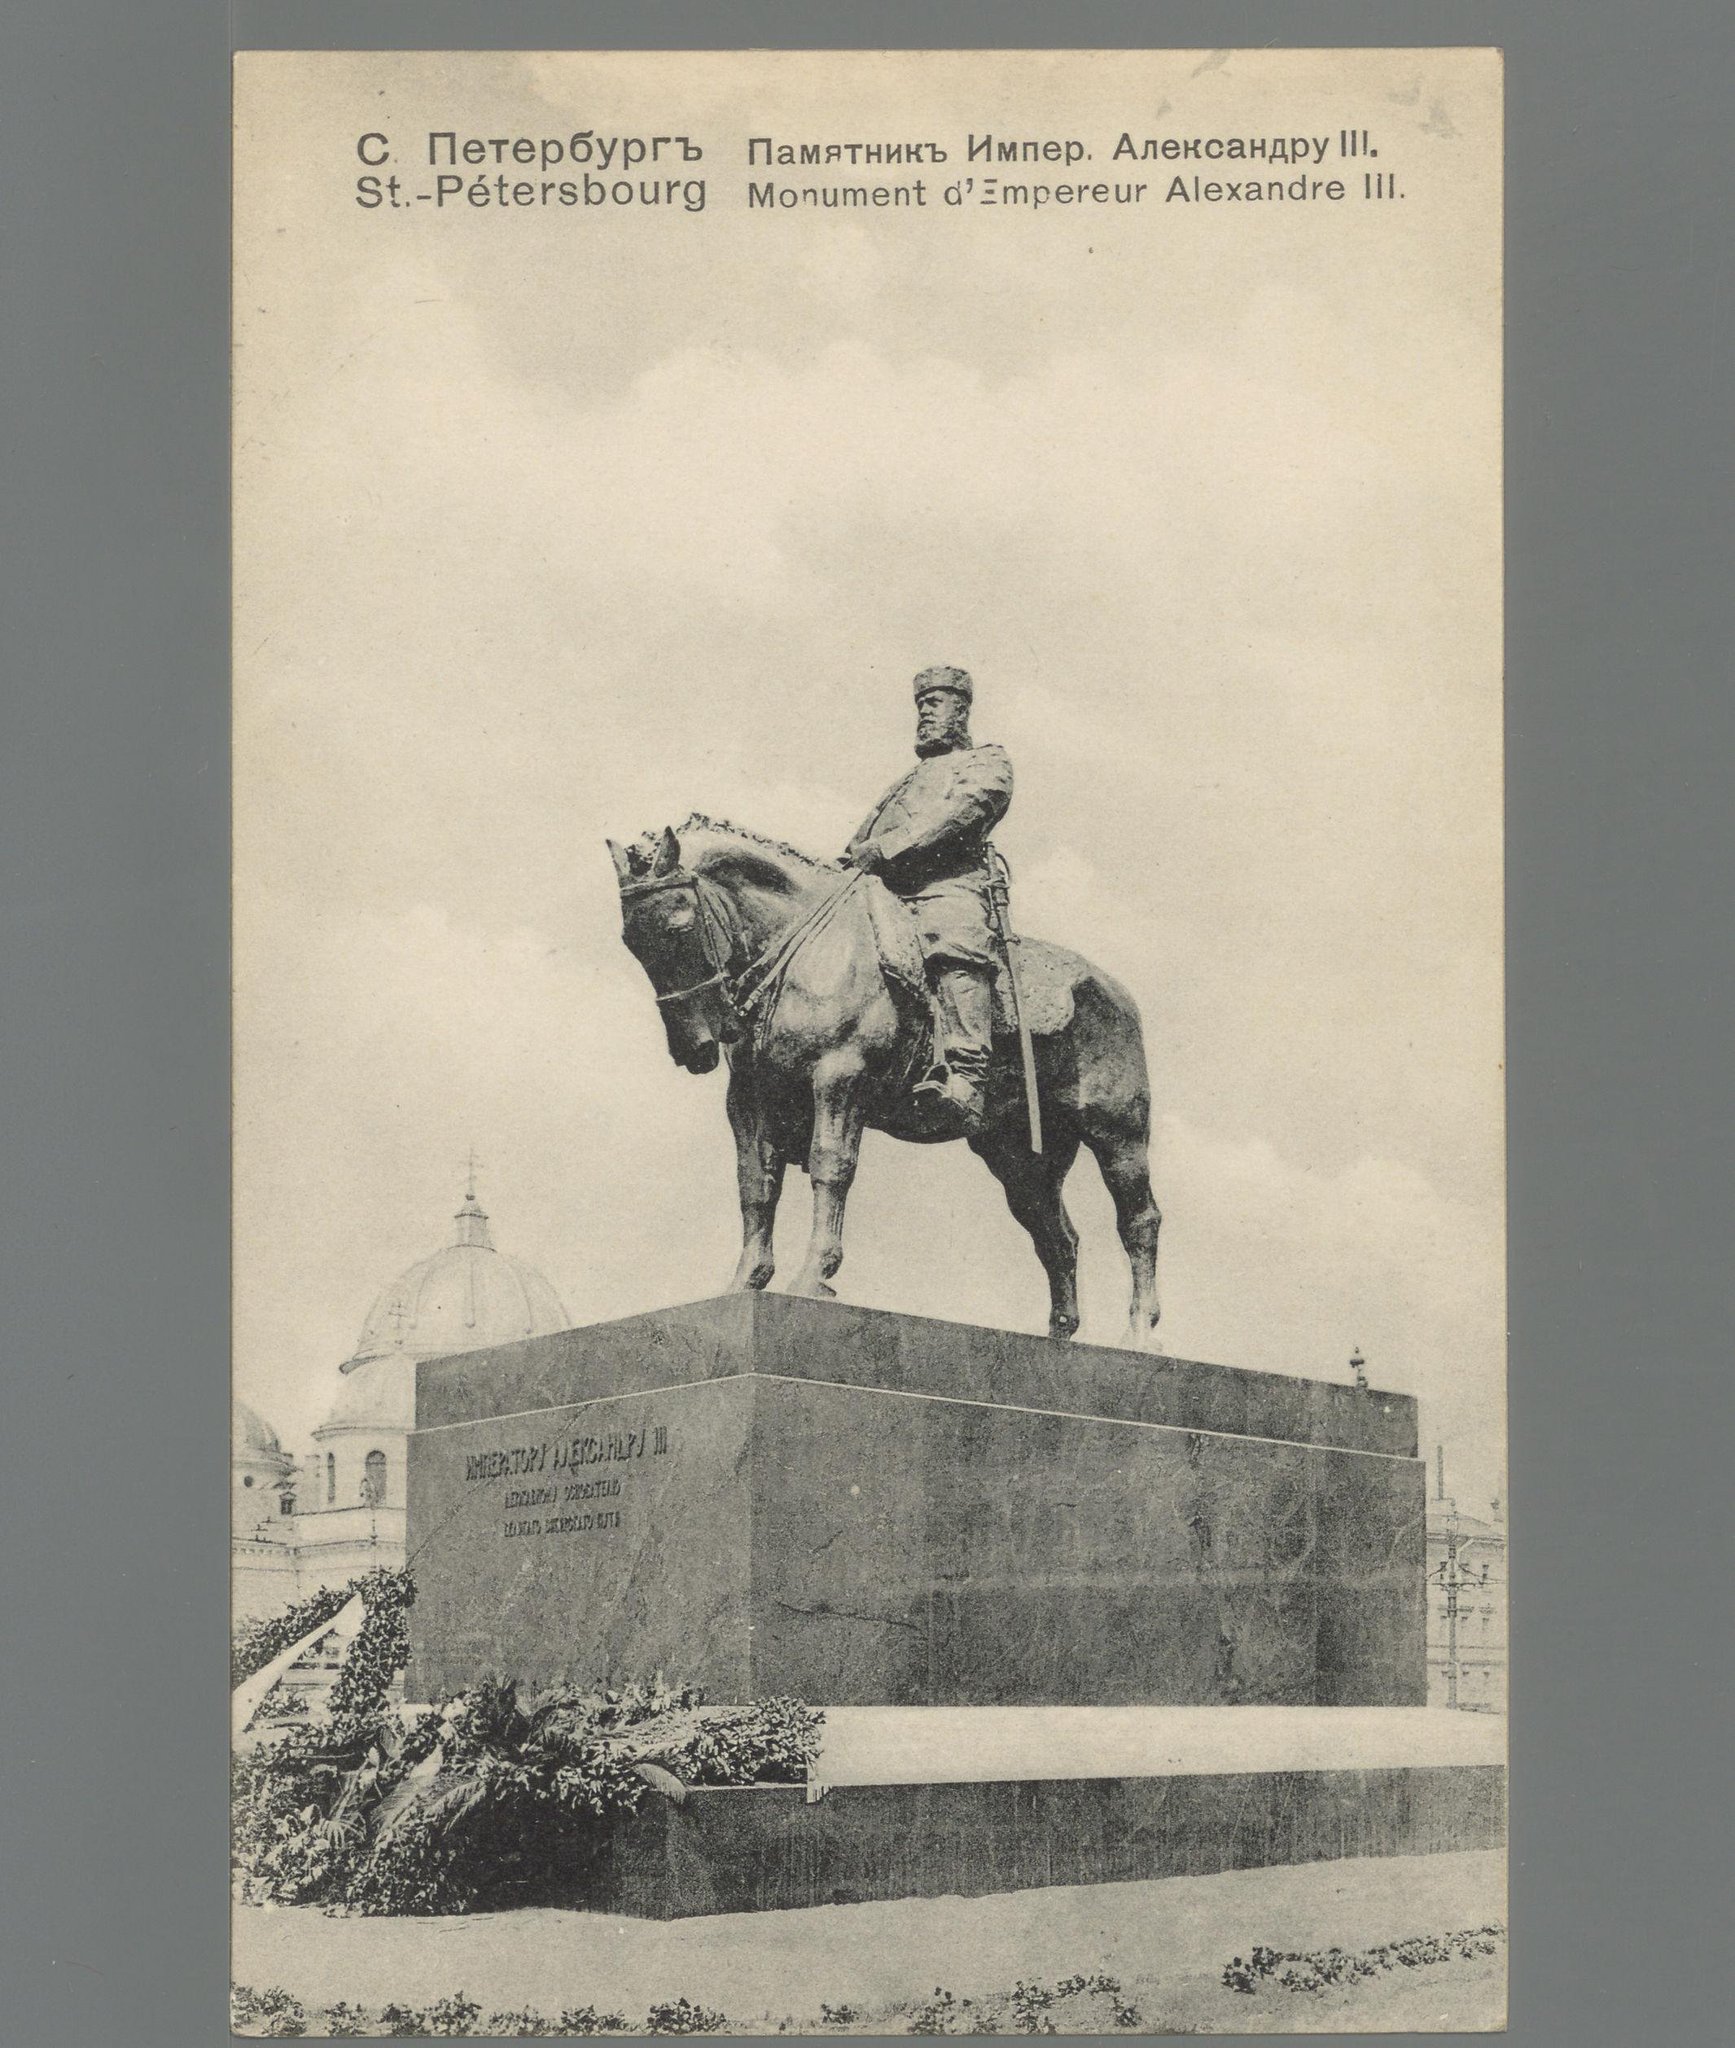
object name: photomechanical print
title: St.-Pétersbourg. Monument d'Empereur Alexandre III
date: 1909-1930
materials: cardboard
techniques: photograph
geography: sint-petersburg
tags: emperor, monument, statue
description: Boven de Franse titel staat de titel in het Russisch.